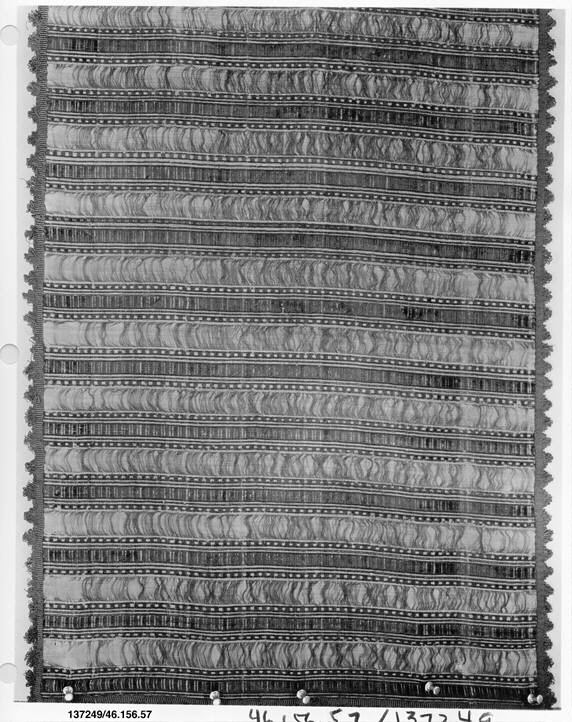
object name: piece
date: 1601-1700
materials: metal thread, silk